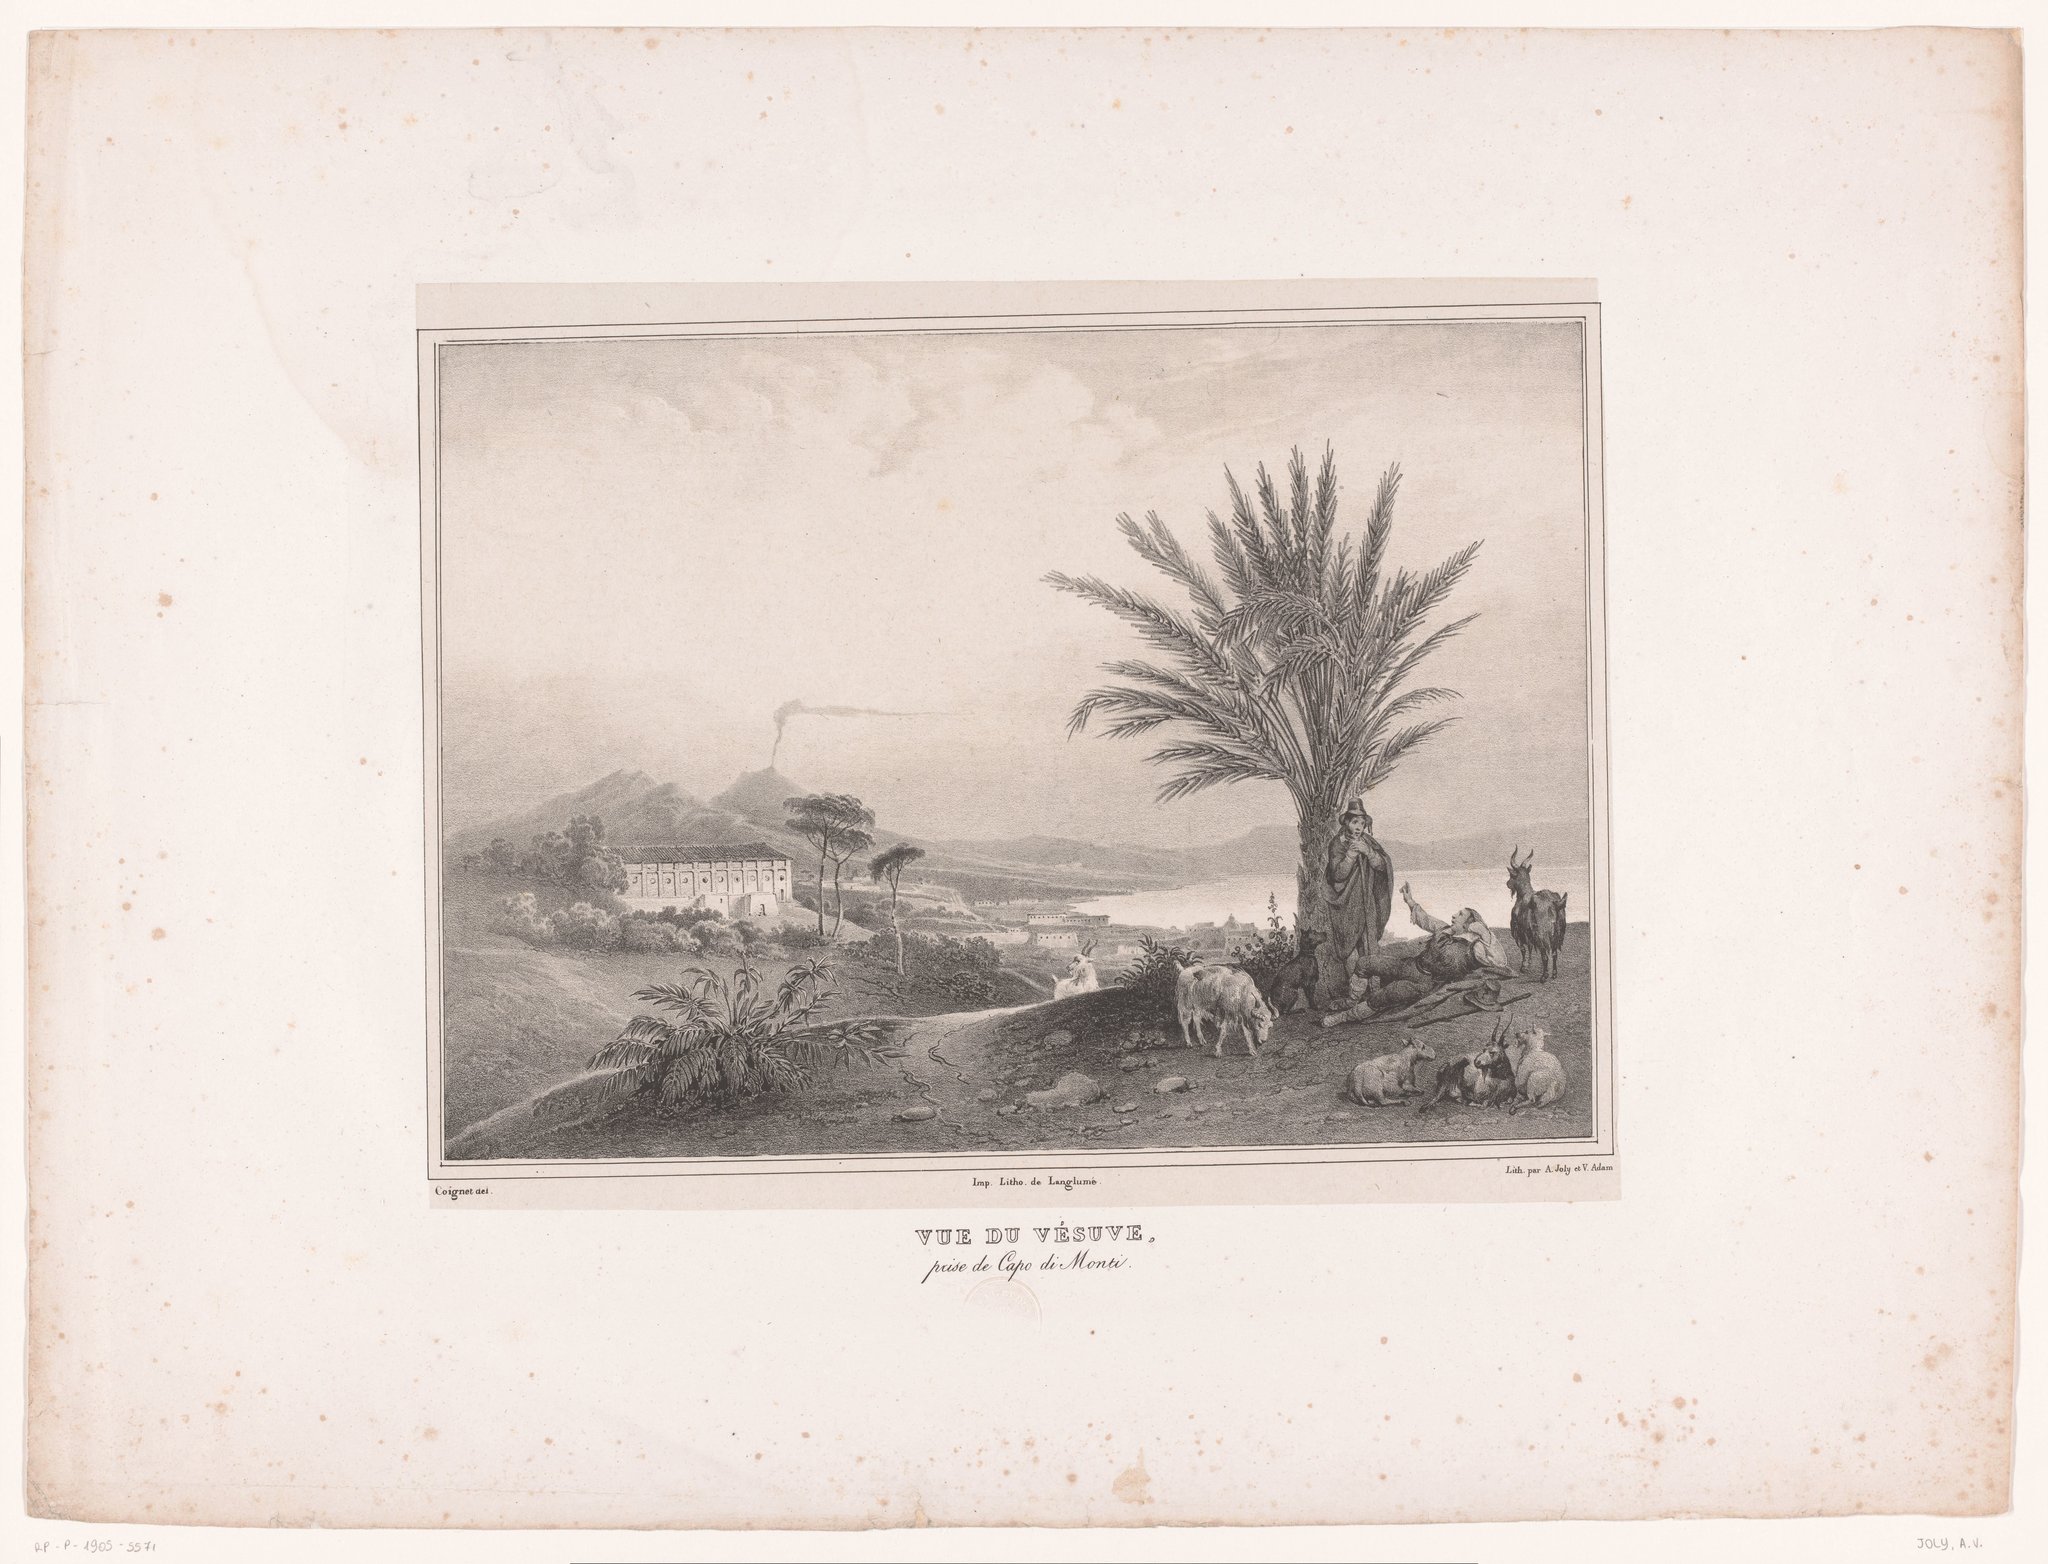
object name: print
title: Vues pittoresques de l'Italie dessinées d'après nature par M. Coignet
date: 1824-1826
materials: paper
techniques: lithograph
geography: paris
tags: gulf, bay (+ landscape with figures, staffage), herding, herdsman, herdswoman, shepherd, shepherdess, cowherd, etc., volcano, mount vesuvius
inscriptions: check stamp: Lugt 3431, collector's mark: Lugt 2228a